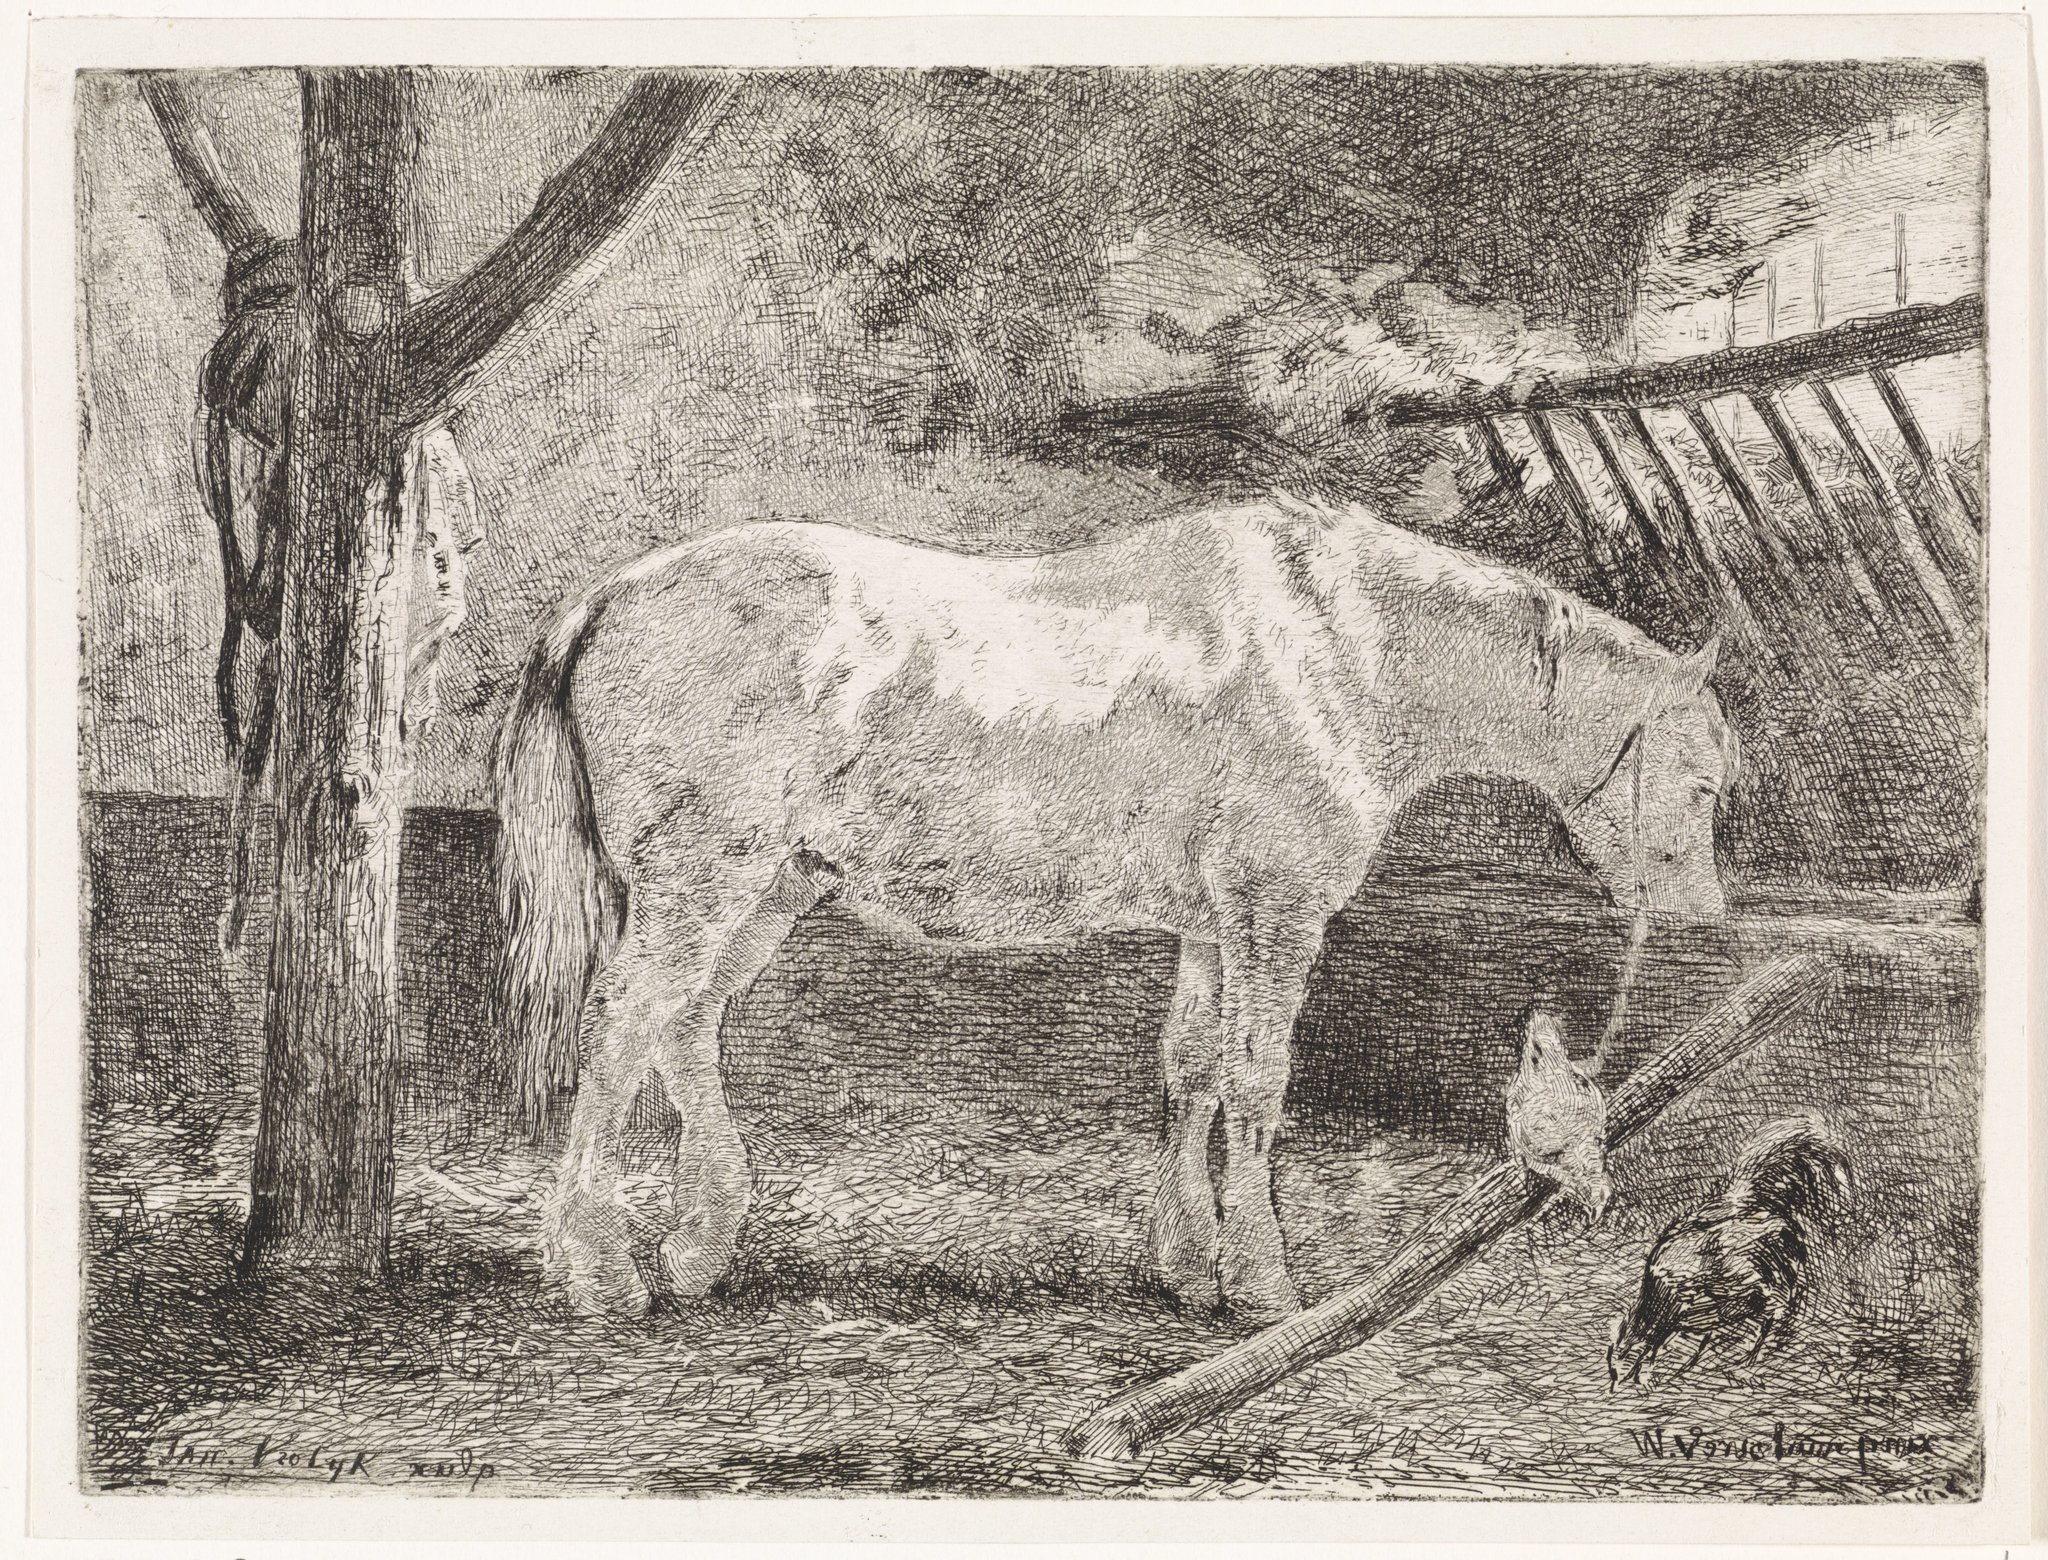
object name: print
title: Paard in stal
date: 1860-1885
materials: paper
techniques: etching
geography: the hague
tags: horses and kindred animals, fowl (cock, hen, chicken, etc.), stall, stable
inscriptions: collector's mark: Lugt 2228